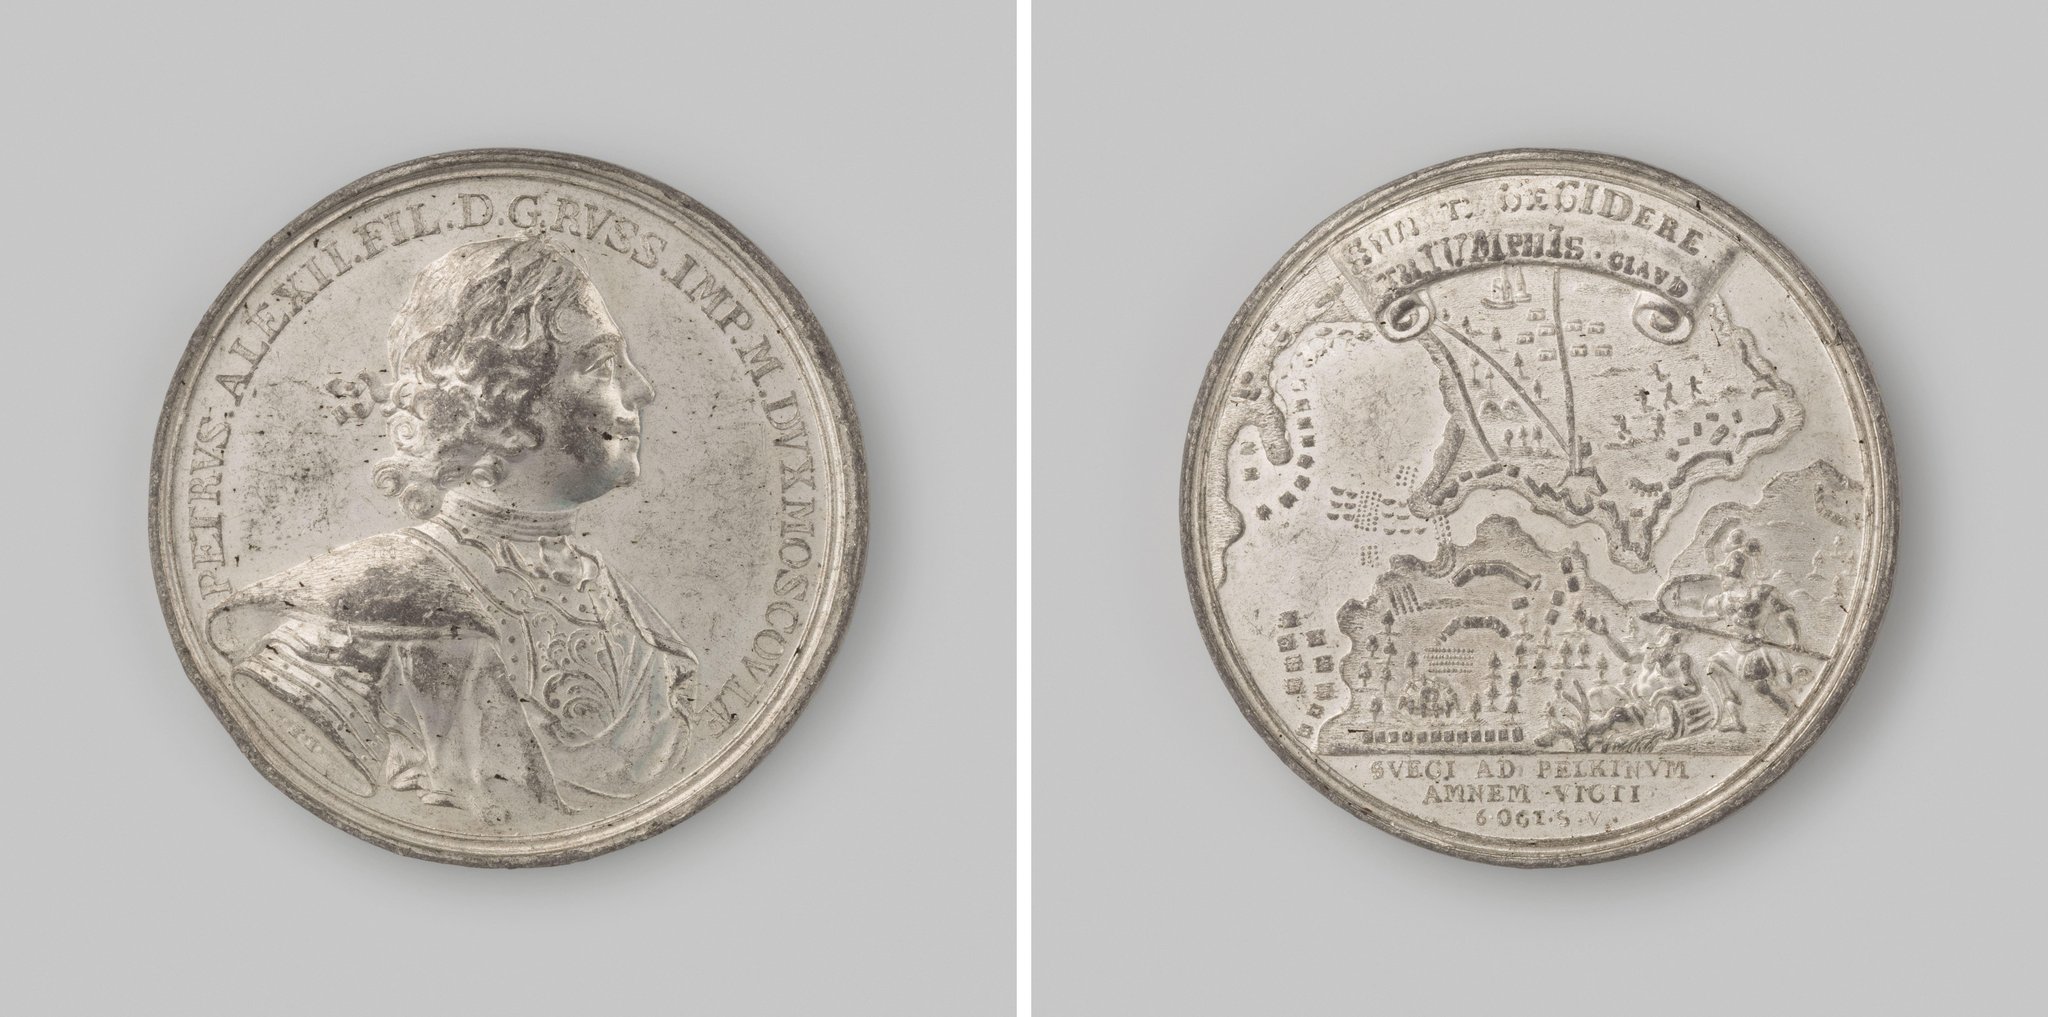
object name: history medal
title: Landing van Russische troepen bij Abo 1713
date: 1713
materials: tin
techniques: striking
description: Tinnen penning, op de voorzijde het borstbeeld van Tsaar Peter de Grote naar rechts met omschrift, op de keerzijde Neptunus die Hercules aan land zet, met omschrift en afsnedetekst.